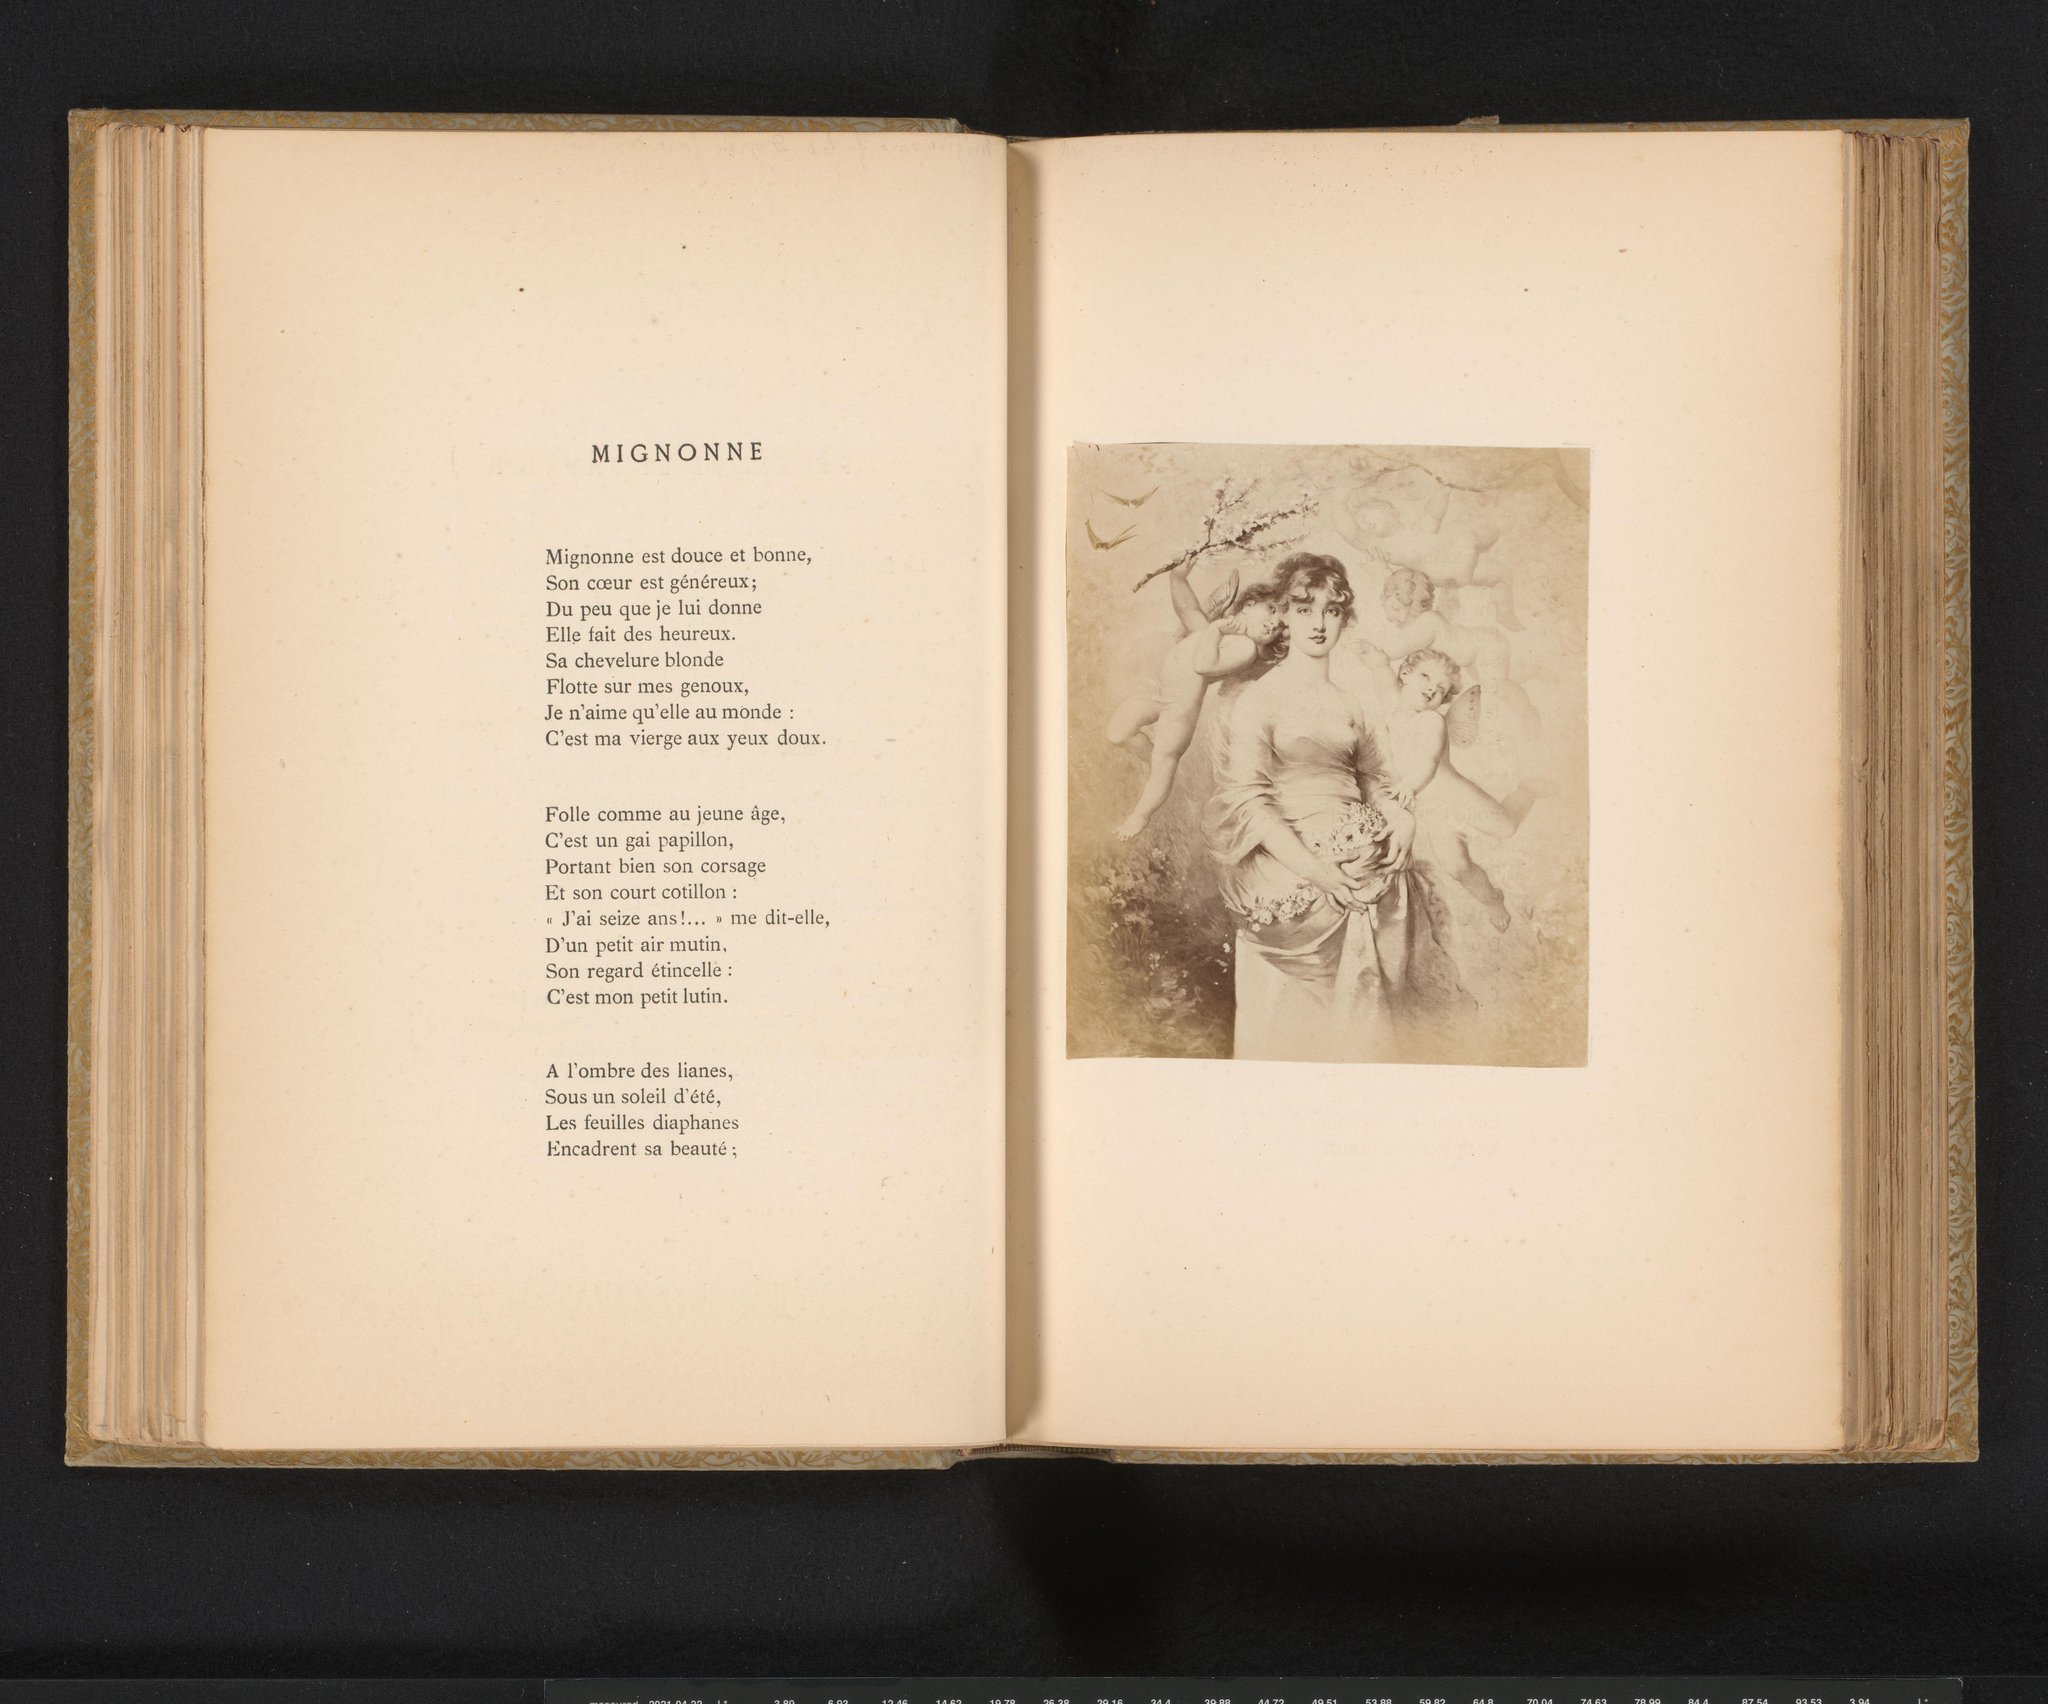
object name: reproduction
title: Fotoreproductie van een schilderij van een vrouw omringd door putti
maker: Anonymous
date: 1874-1884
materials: paper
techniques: albumen print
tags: adult woman, picture, painting, cupids: 'amores', 'amoretti', 'putti'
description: Foto op vijfde ongenummerde pagina na pagina 56.